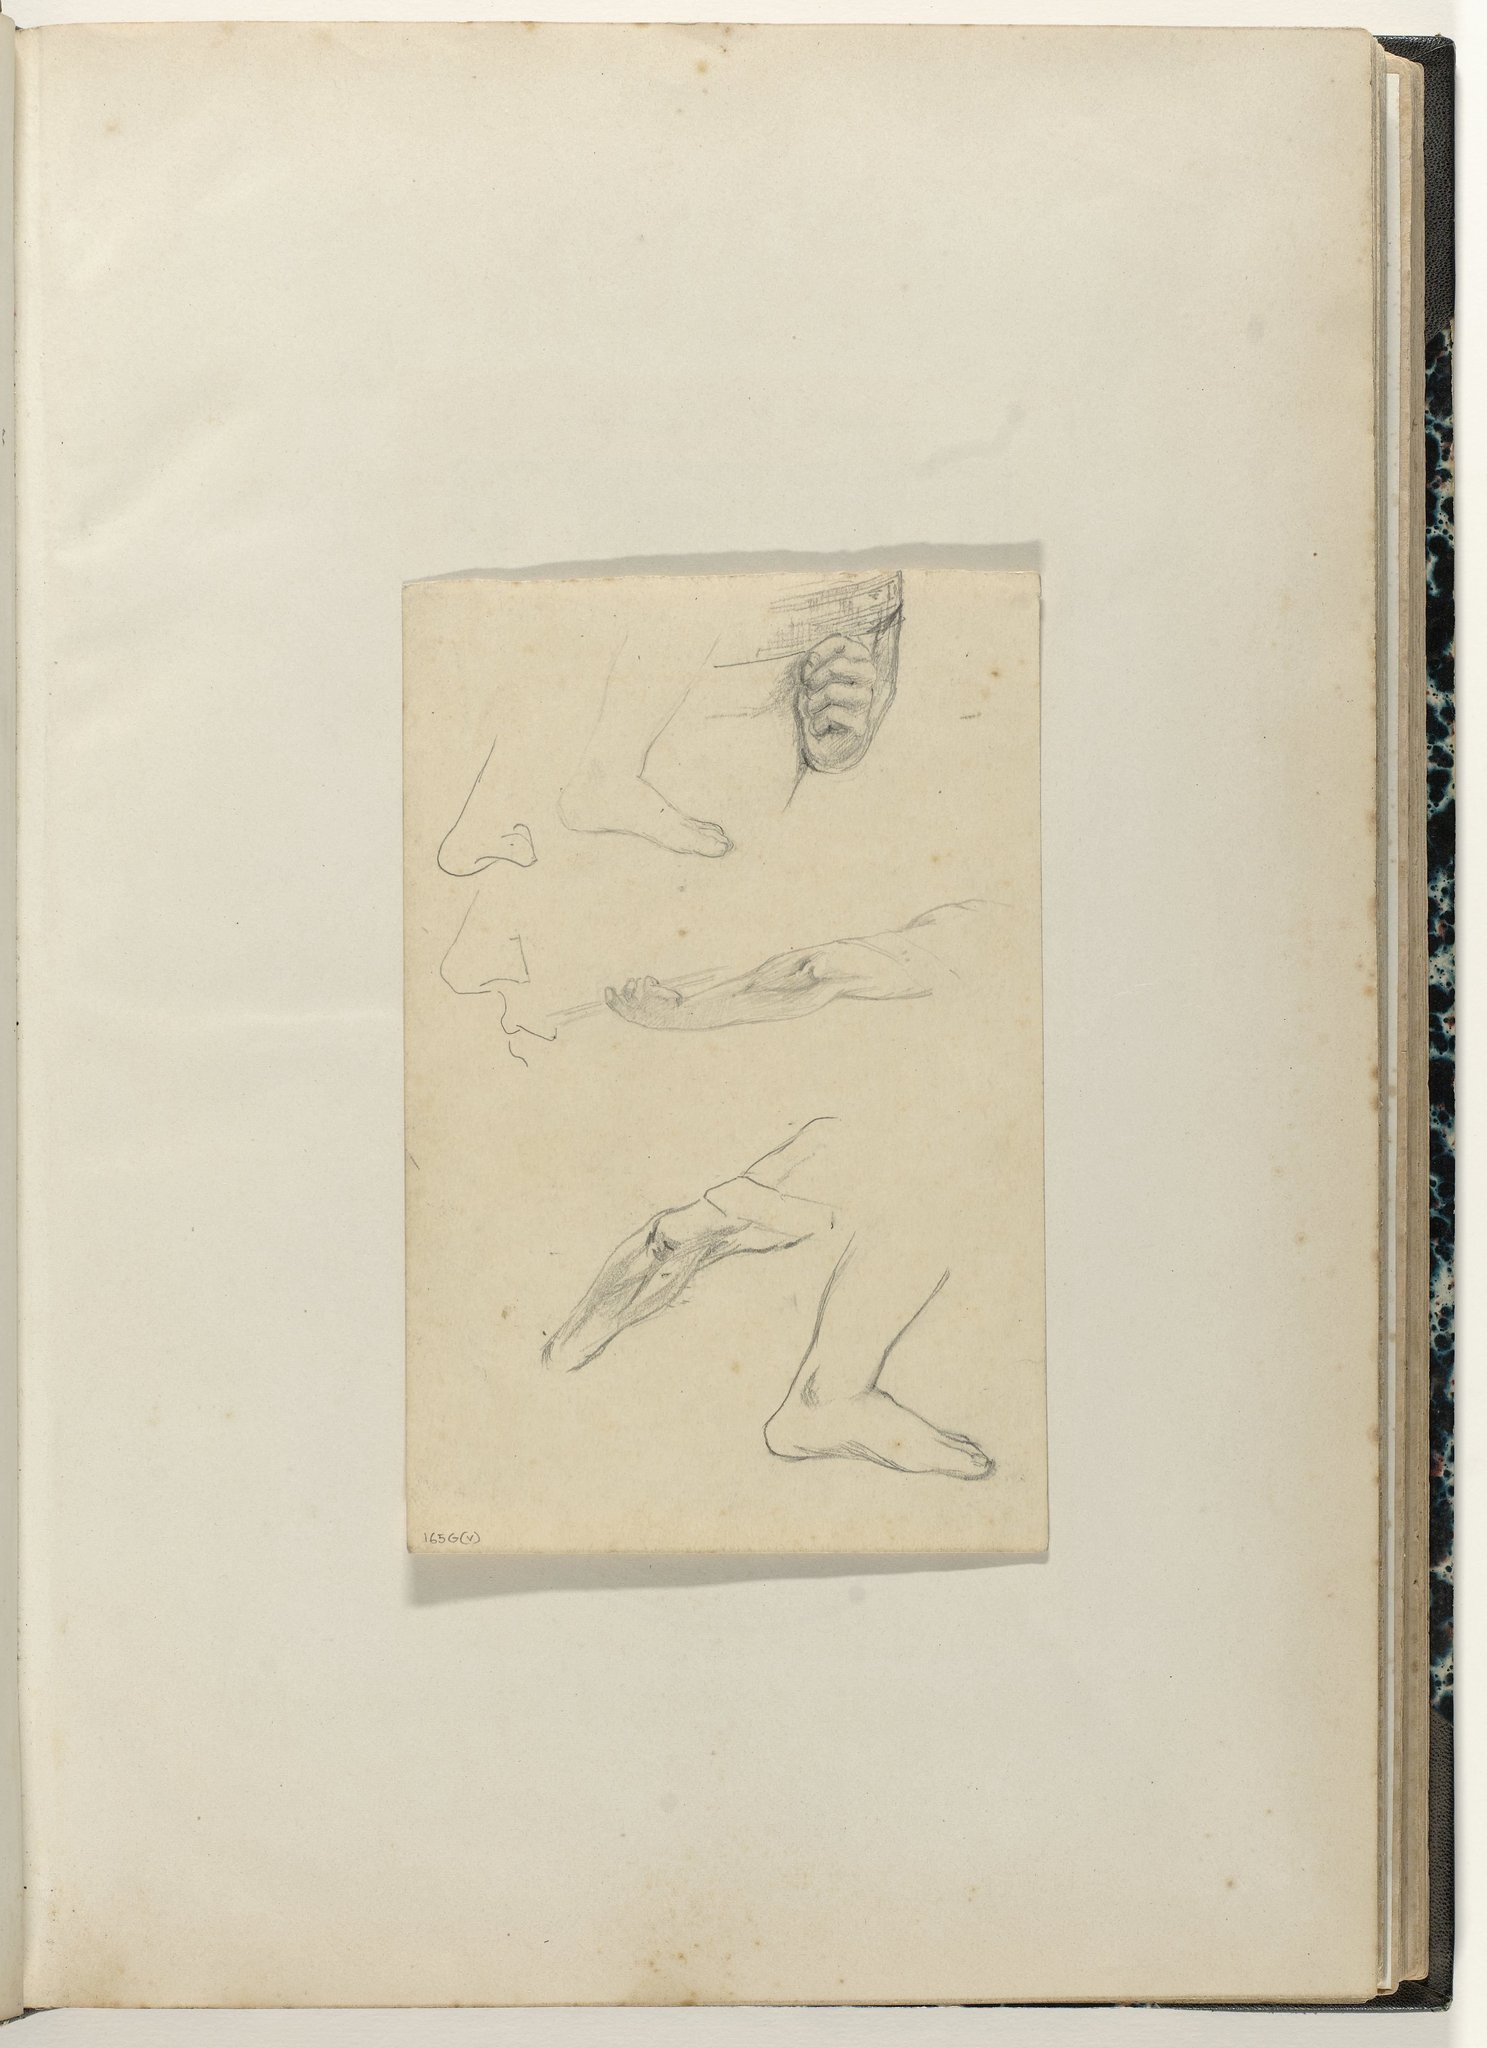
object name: drawing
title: Studies van lichaamsdelen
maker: Anonymous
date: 1866-1900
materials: paper, pencil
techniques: drawing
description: Studies van neus, voet, hand, arm en been.